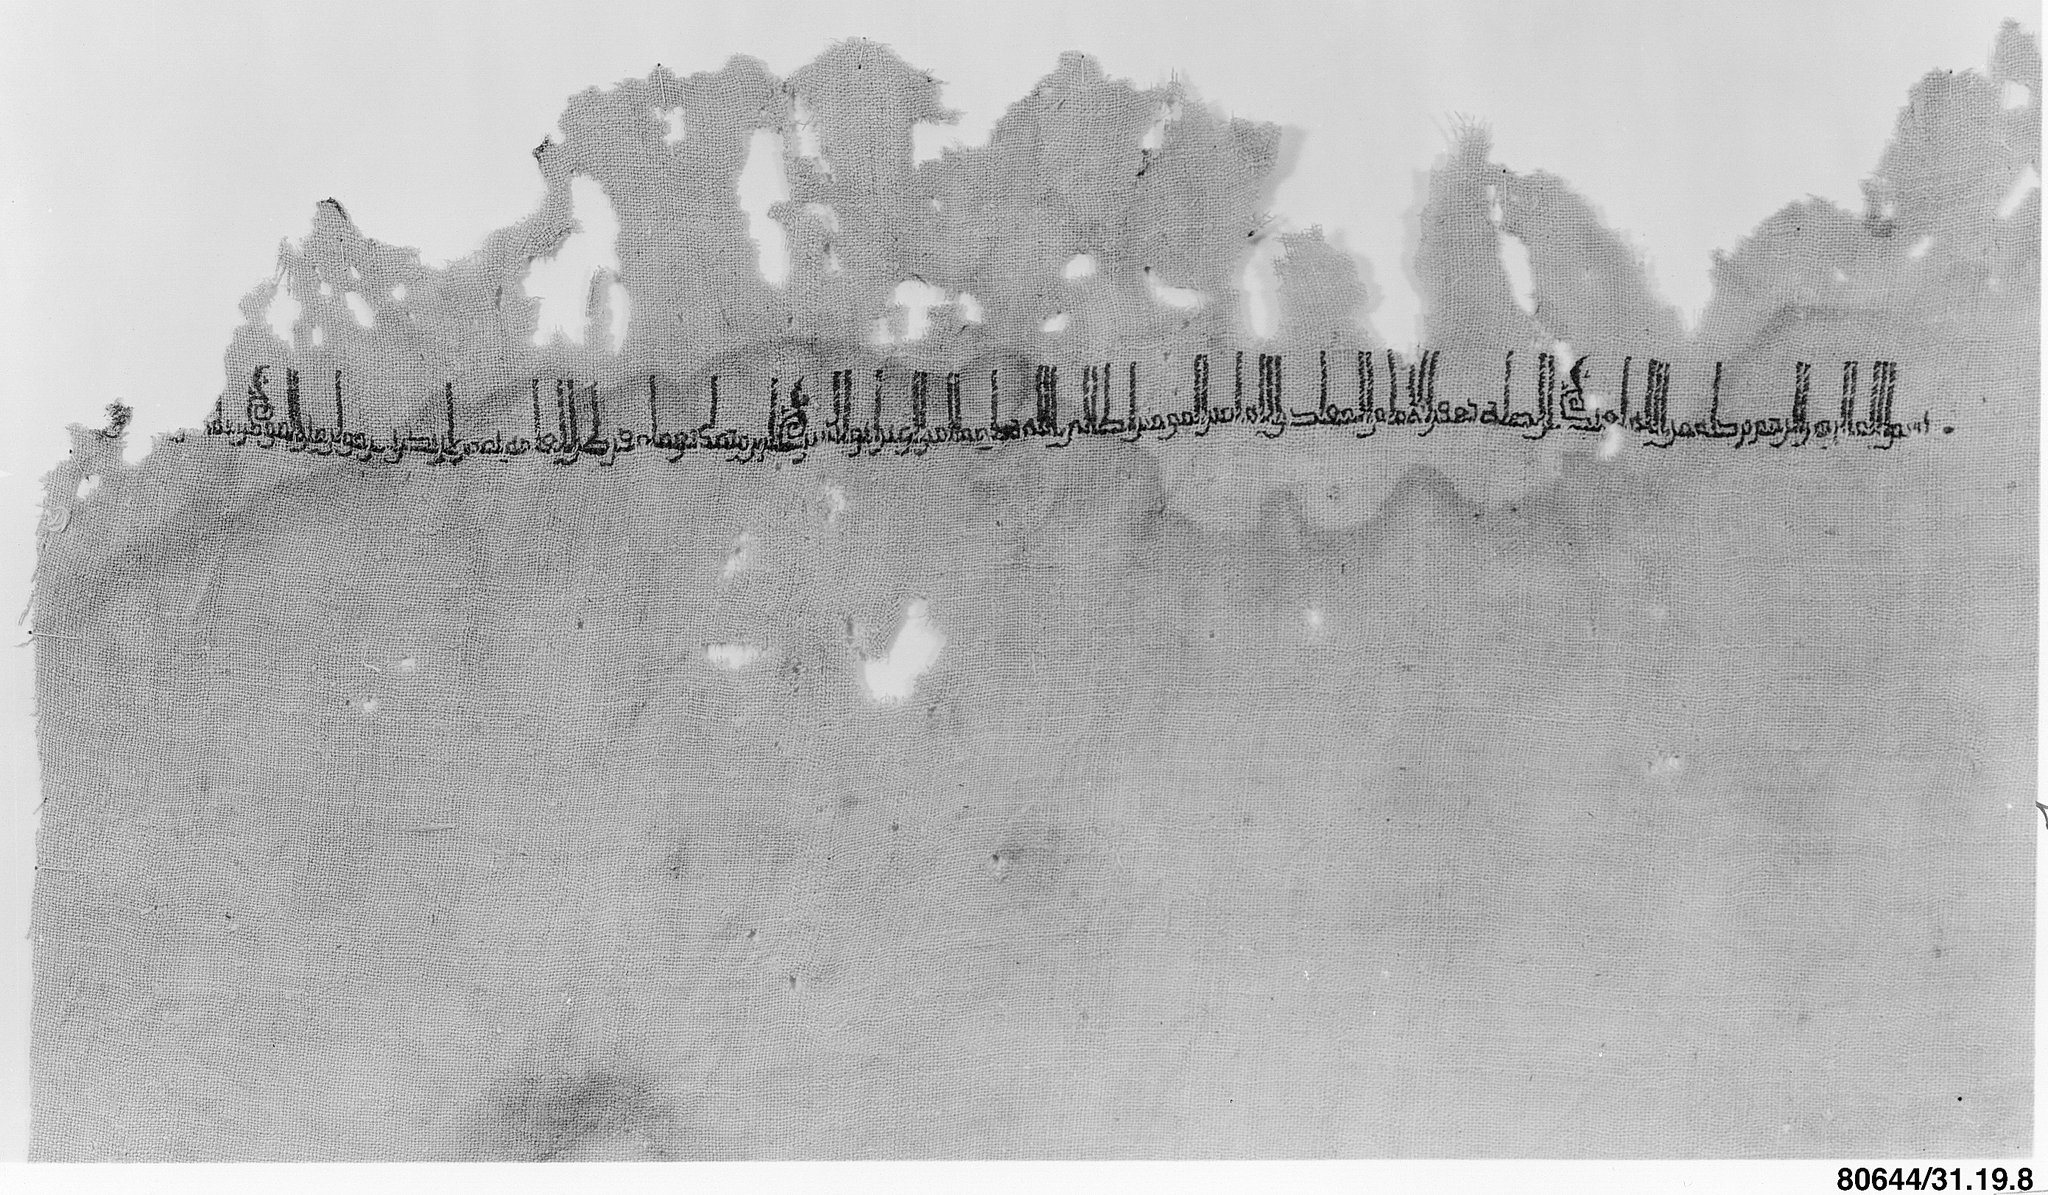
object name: fragment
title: Textile Fragment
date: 901-1000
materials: linen, silk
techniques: embroidery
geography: egypt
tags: arabic